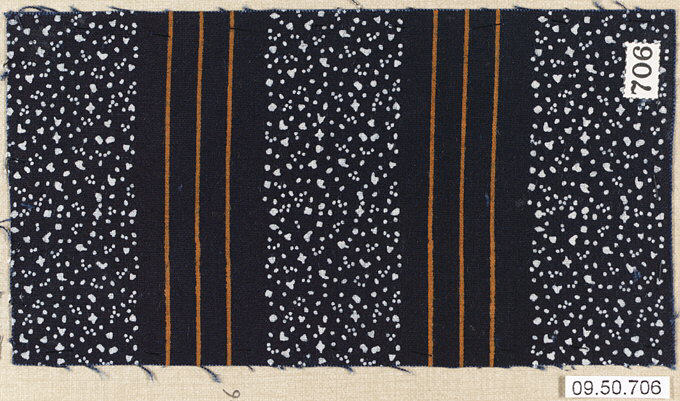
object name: piece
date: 1801-1900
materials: cotton